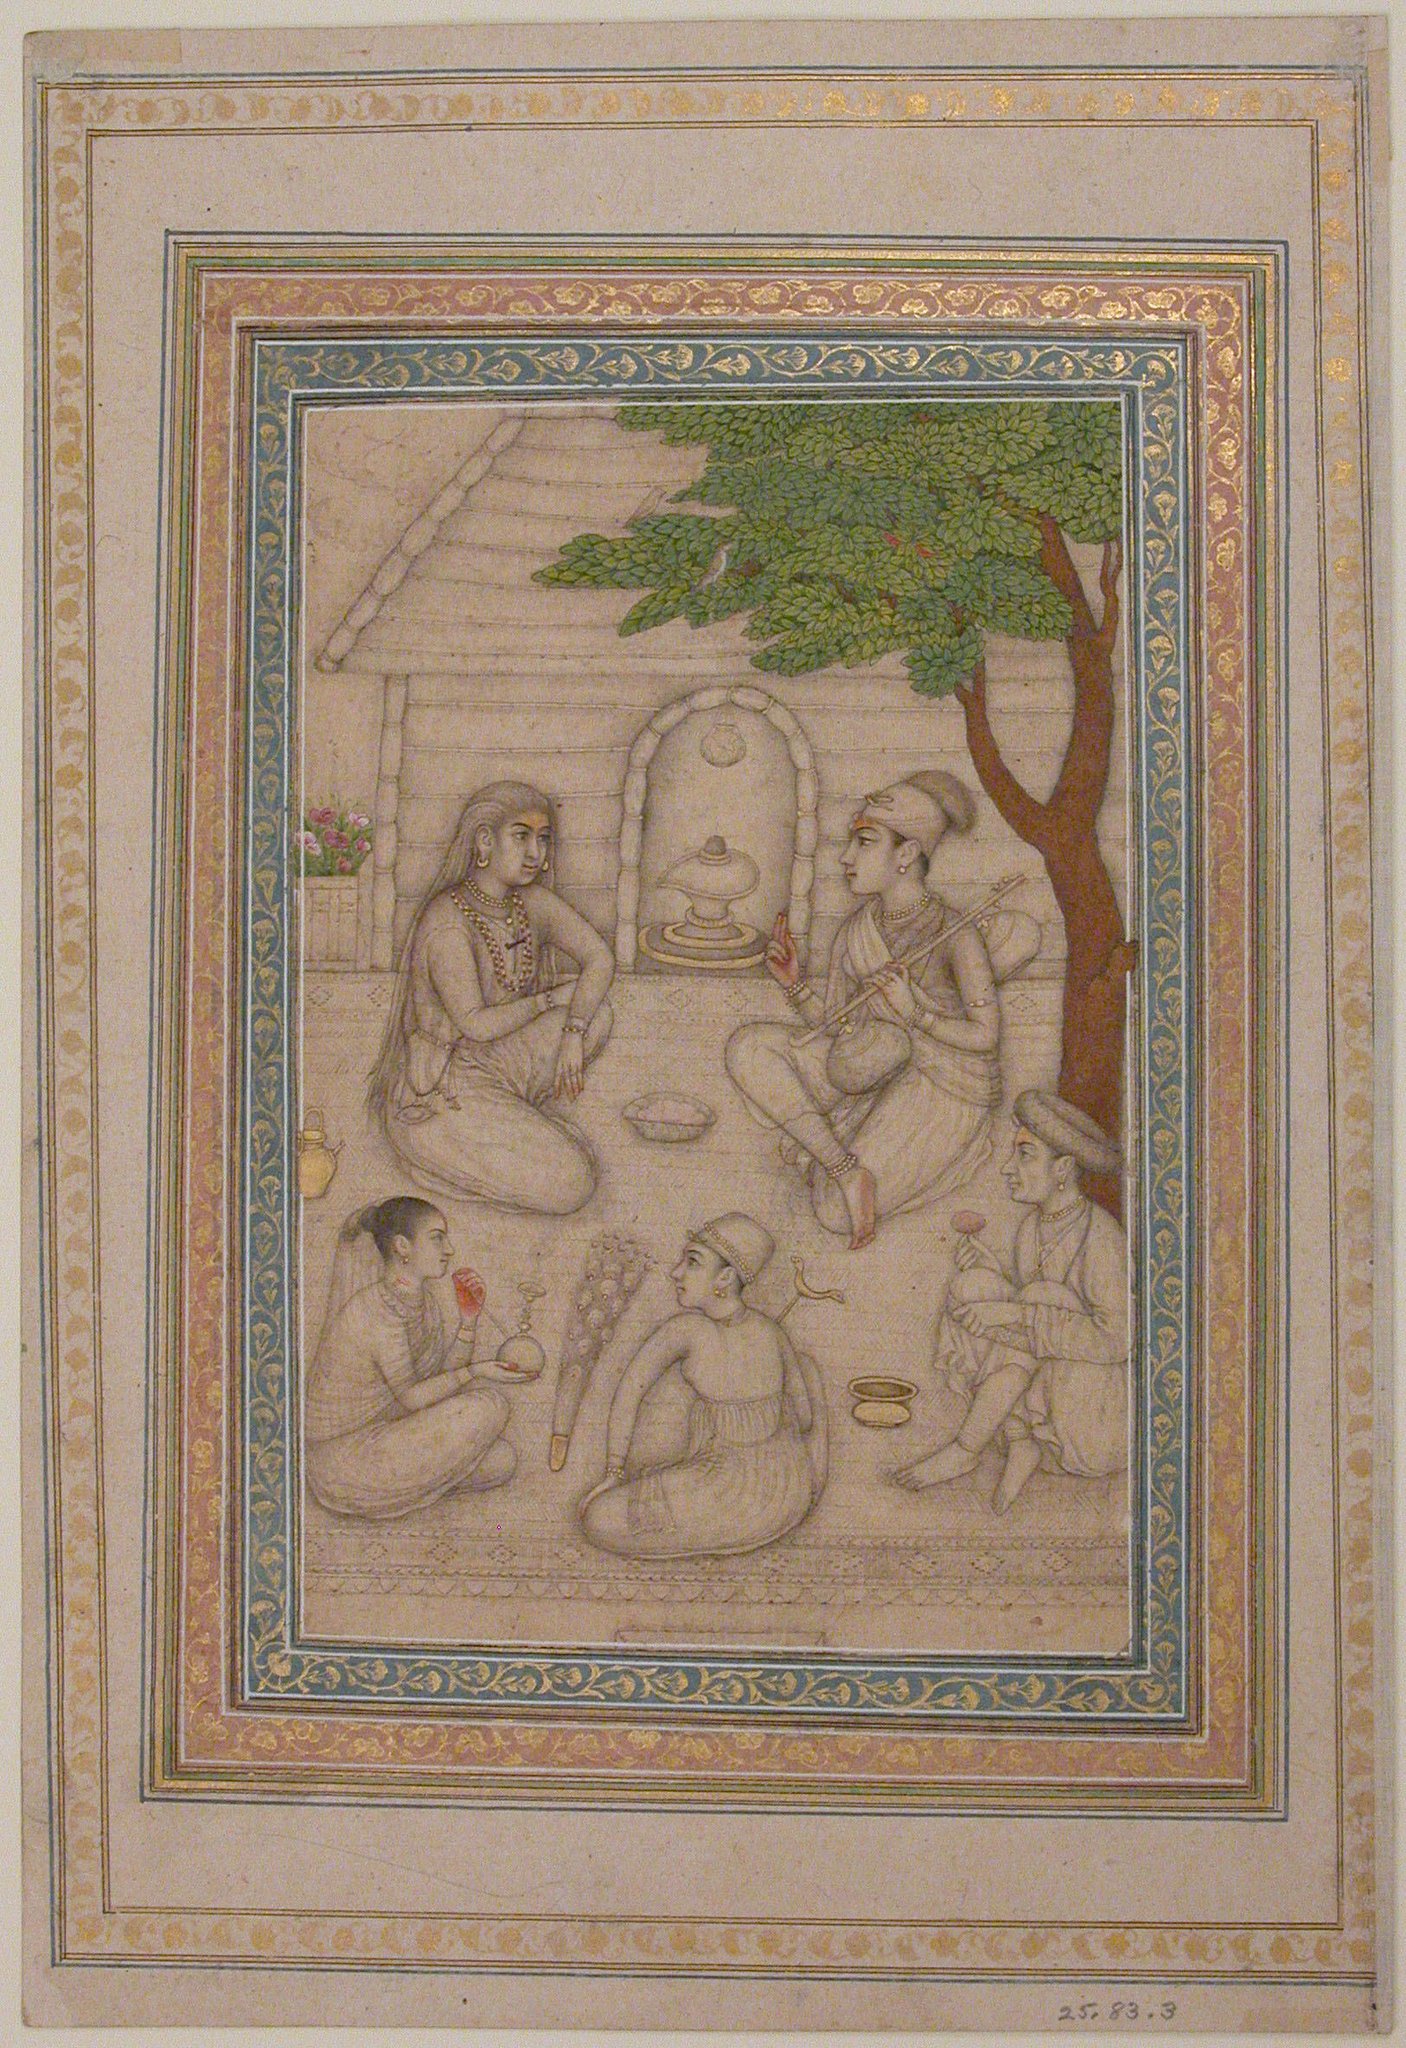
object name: album leaf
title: Hindus Conversing before a Shrine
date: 1601-1700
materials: gold, ink, paper, watercolor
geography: india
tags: men,women,smoking,hookah